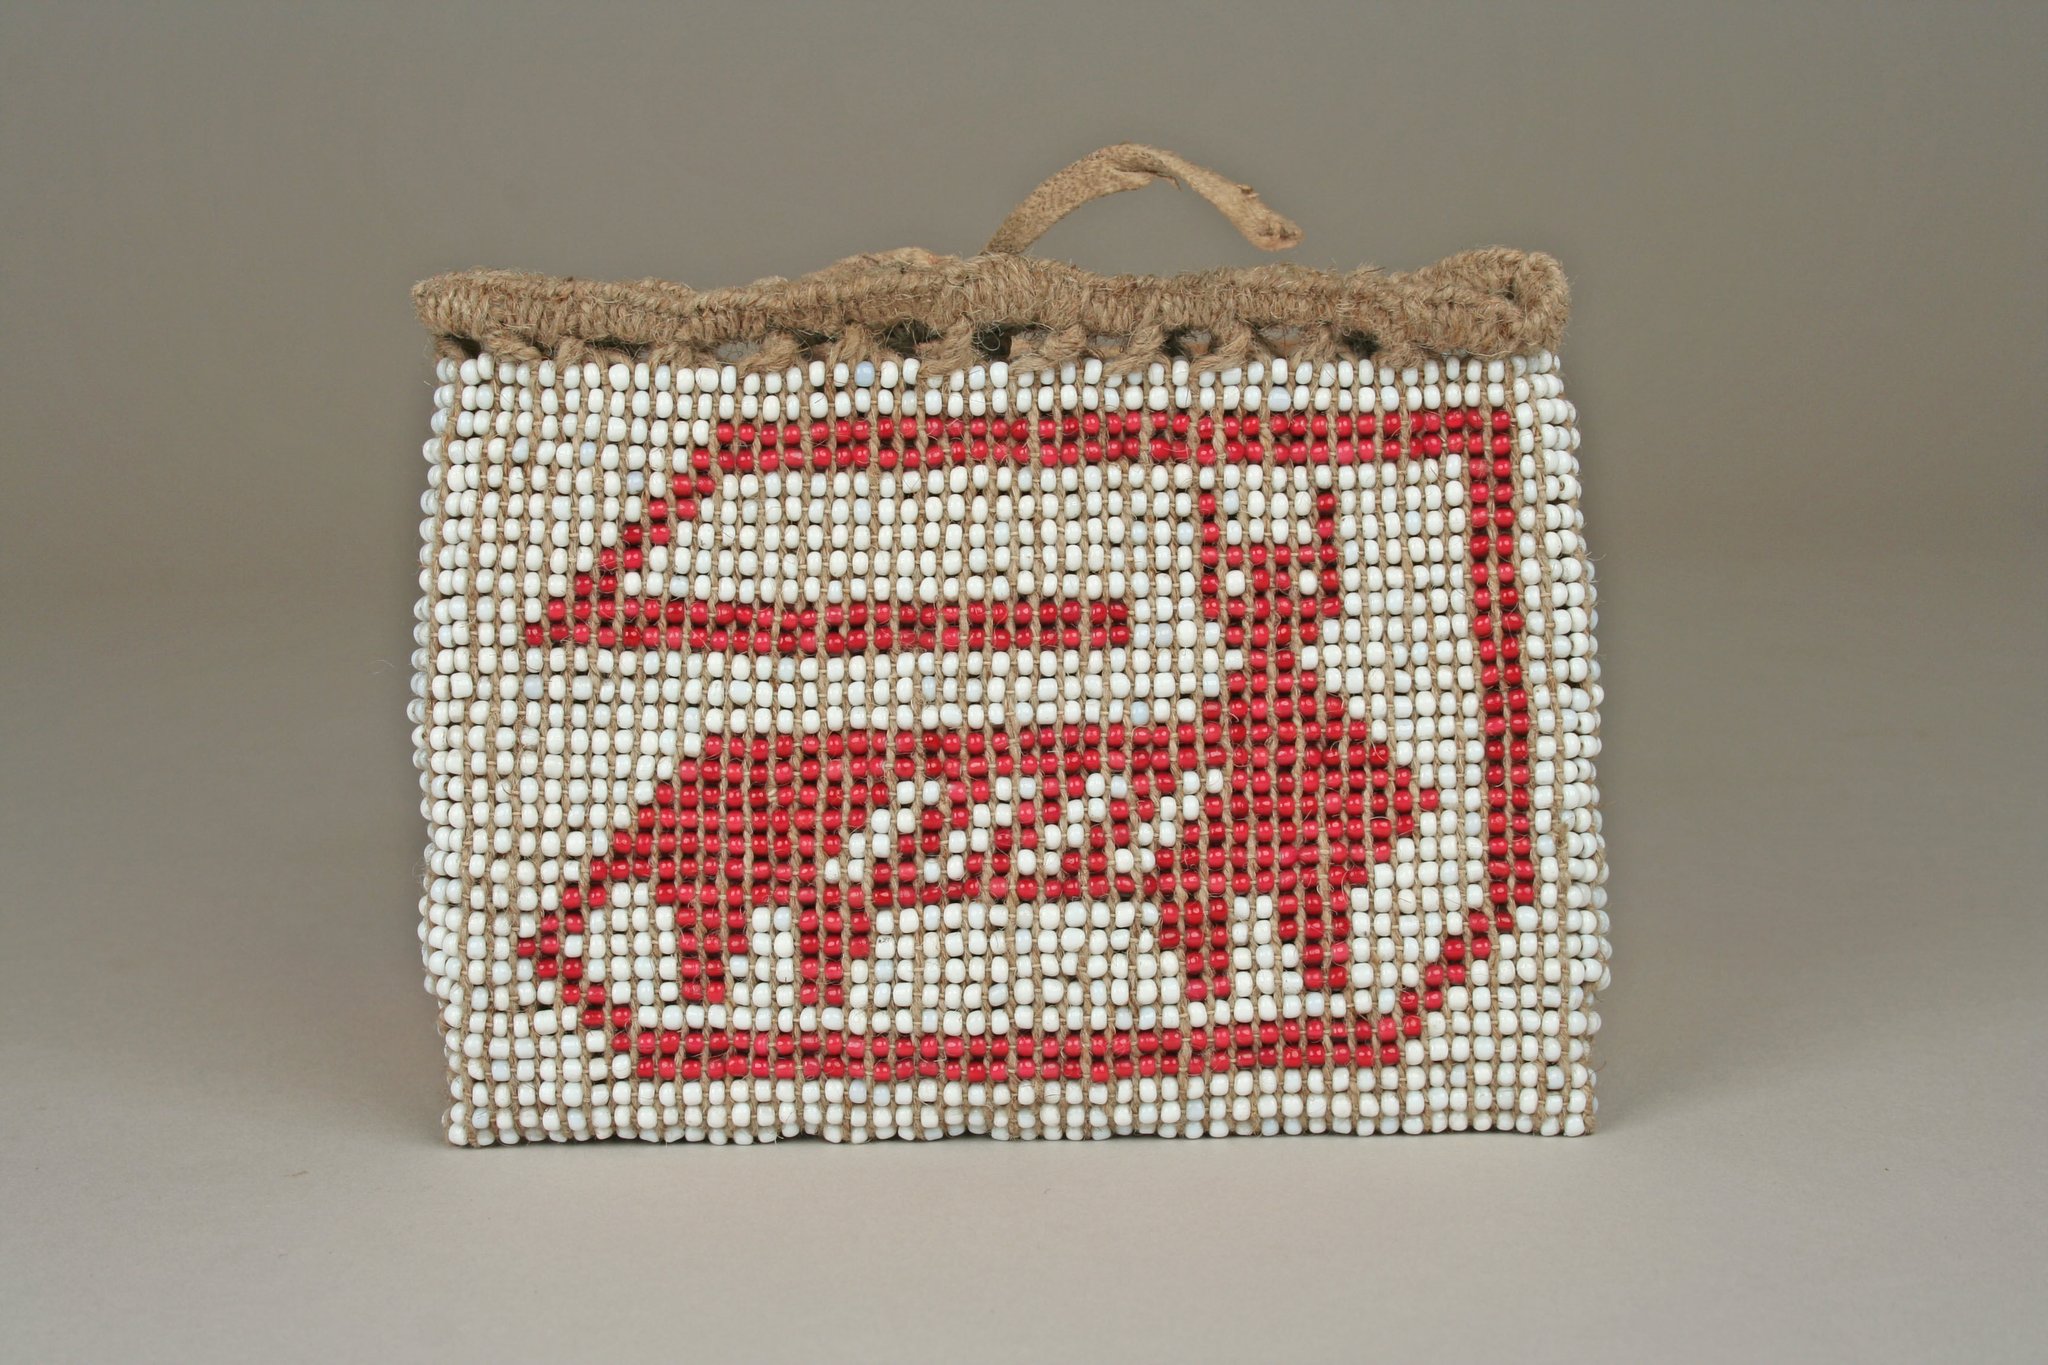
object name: charm bag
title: Business Bundle Bag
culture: mesquakie or potawatomi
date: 1790-1890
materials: glass, skin, wool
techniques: tanning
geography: united states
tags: animals